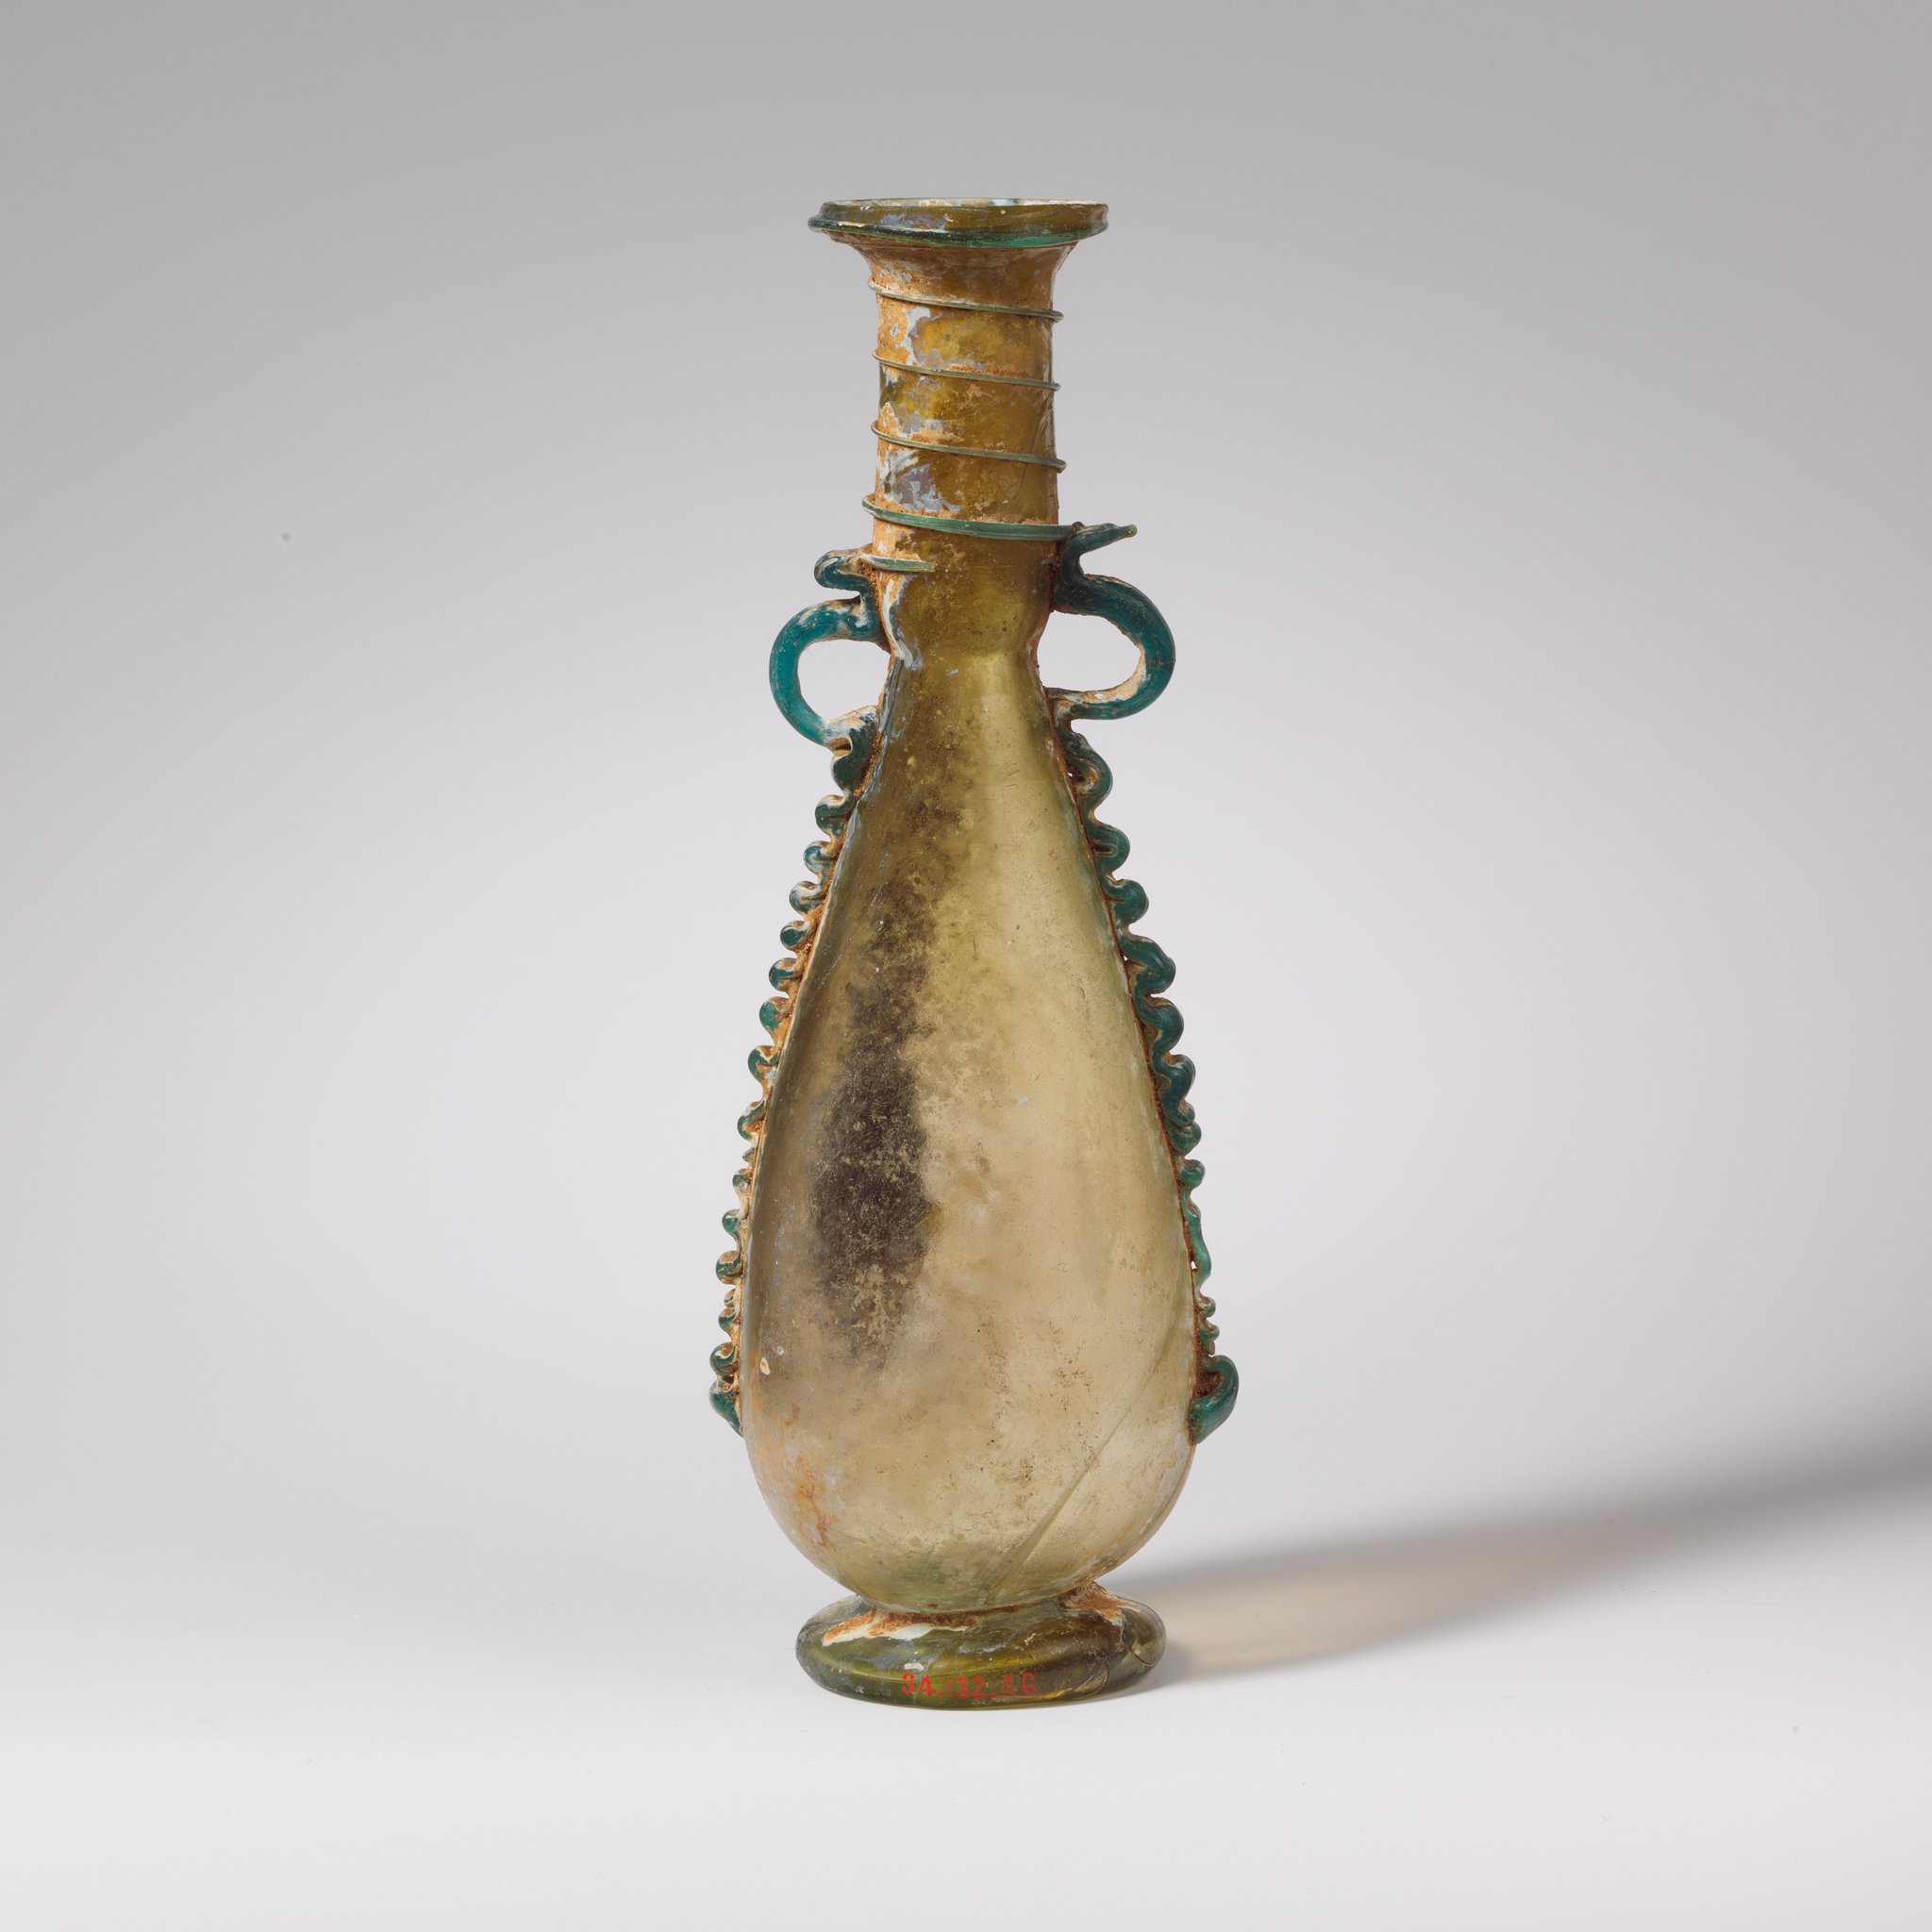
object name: bottle, two handled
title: Glass bottle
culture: roman, syrian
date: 401-500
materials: glass